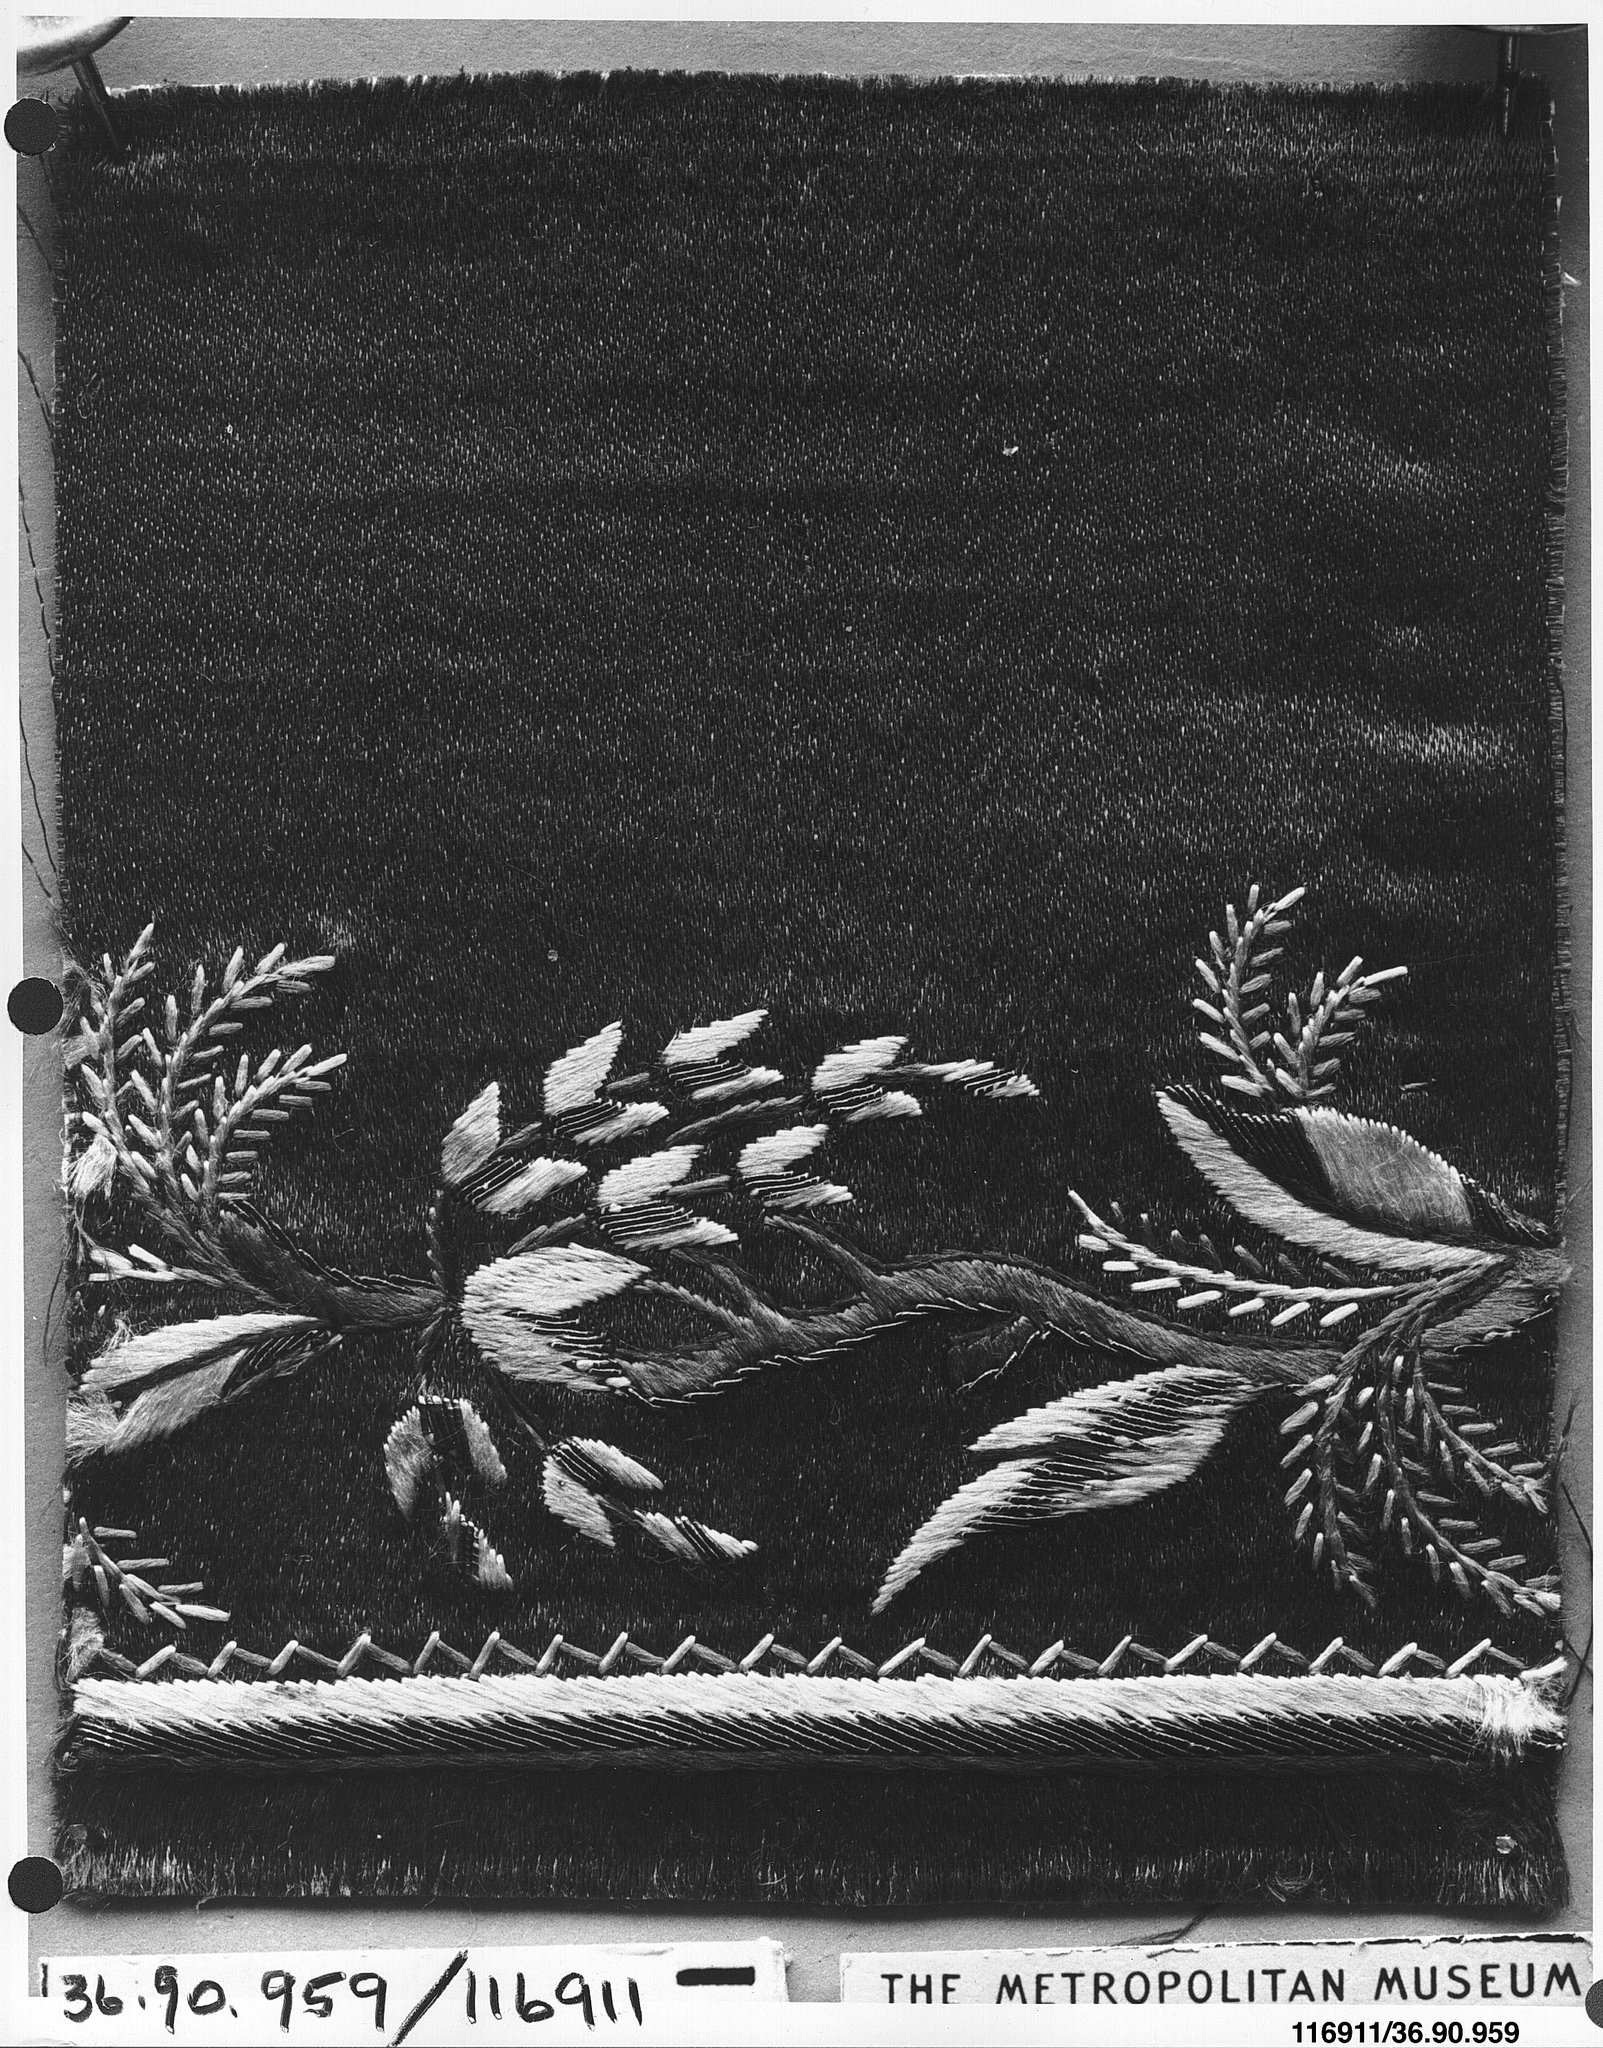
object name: sample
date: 1801-1833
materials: silk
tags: flowers